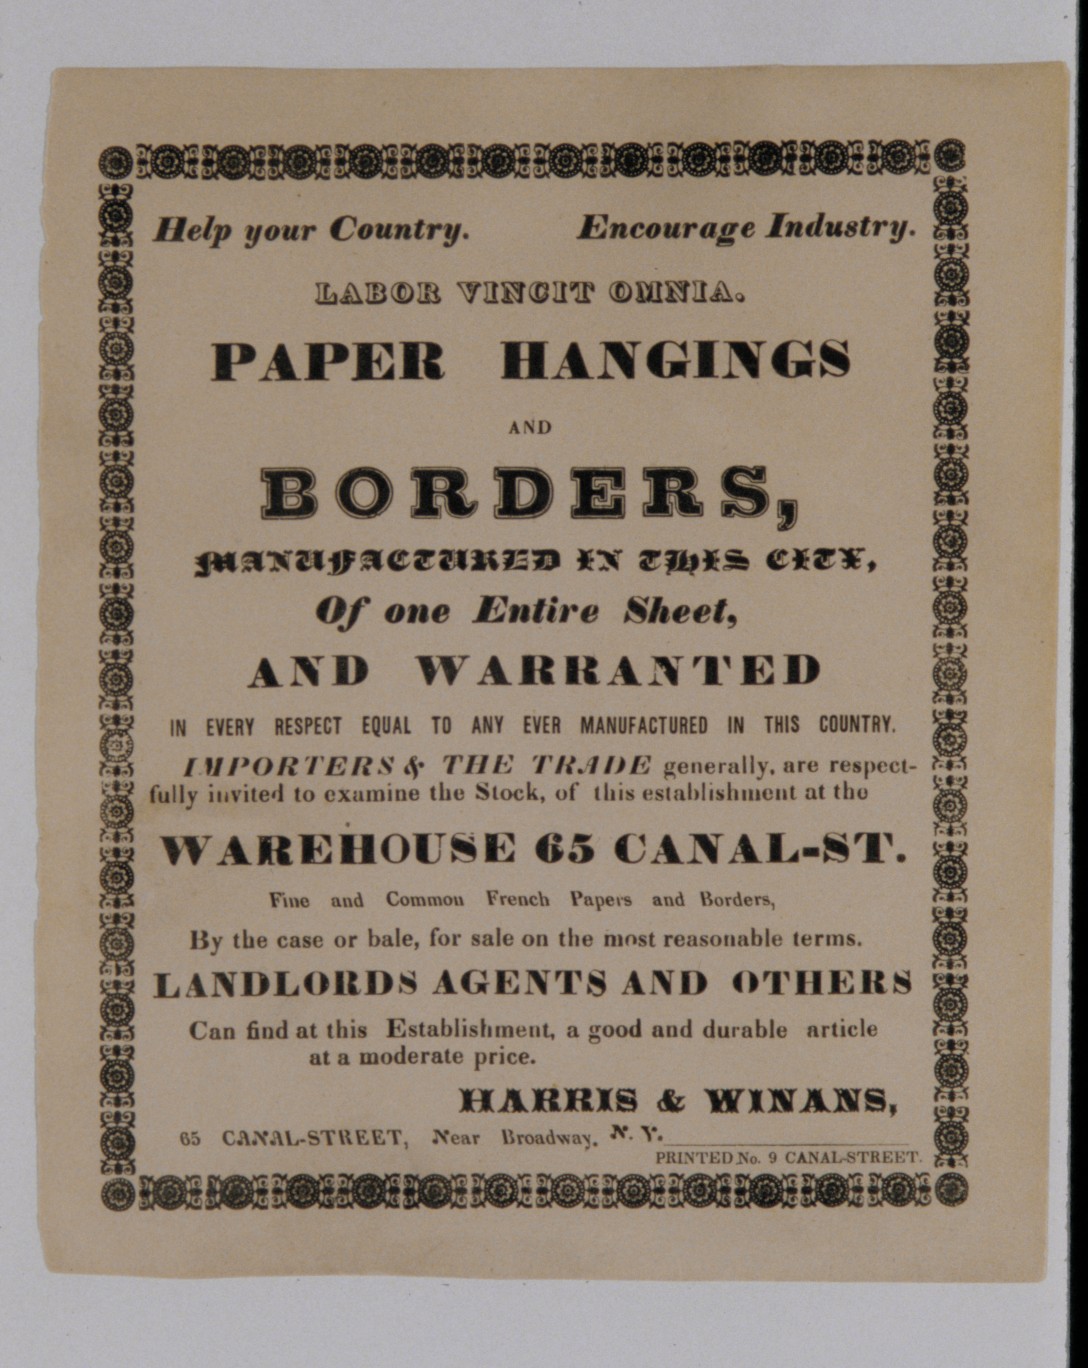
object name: print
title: Help Your Country, Encourage Industry, Labor Vincit Omnia, Paper Hangings and Borders, Manufactured in this City, Of one Entire Sheet, and Warrented, in every respect equal to any ever manufactured in this country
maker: harris & winans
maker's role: author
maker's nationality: american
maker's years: 1800-1900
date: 1835-1837